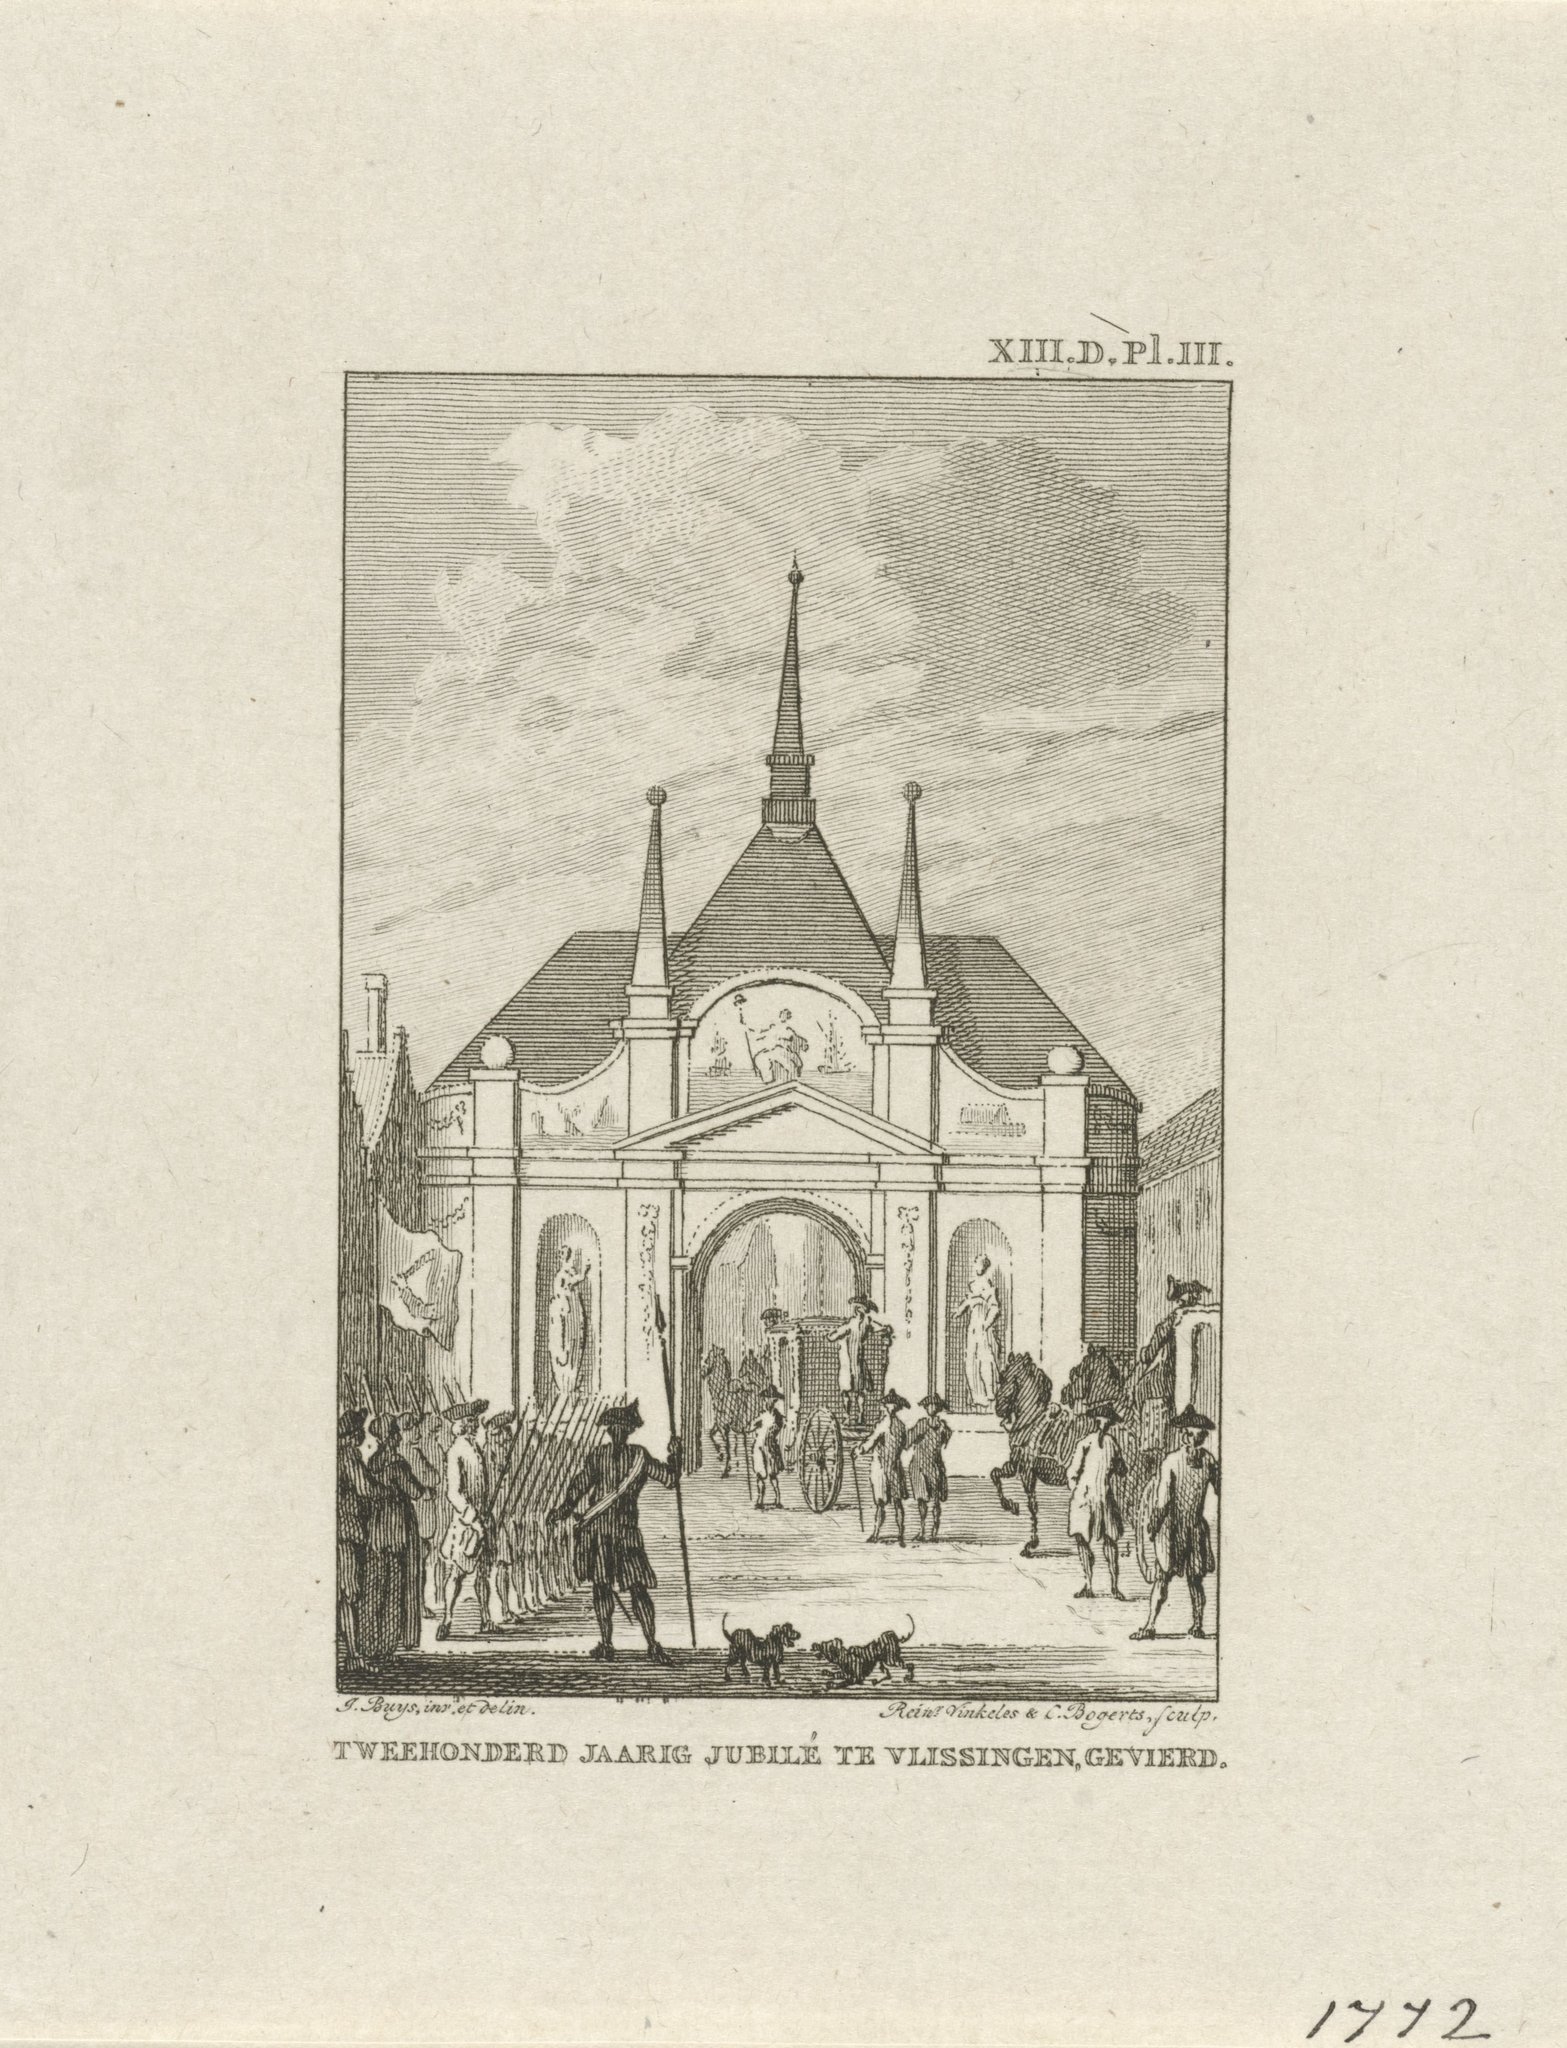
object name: history print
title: Triomfpoort ter ere van 200 jaar vrijheid in Vlissingen, 1772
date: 1780-1795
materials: paper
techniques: etching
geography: northern netherlands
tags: triumphal arch, flushing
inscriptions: collector's mark: Lugt 2228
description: Triomfpoort opgericht in de stad bij de viering van 200 jaar vrijheid in Vlissingen, 6 april 1772. Rijtuigen rijden door de erepoort of tempel. Gemerkt rechtsboven: XIII.D.Pl.III.